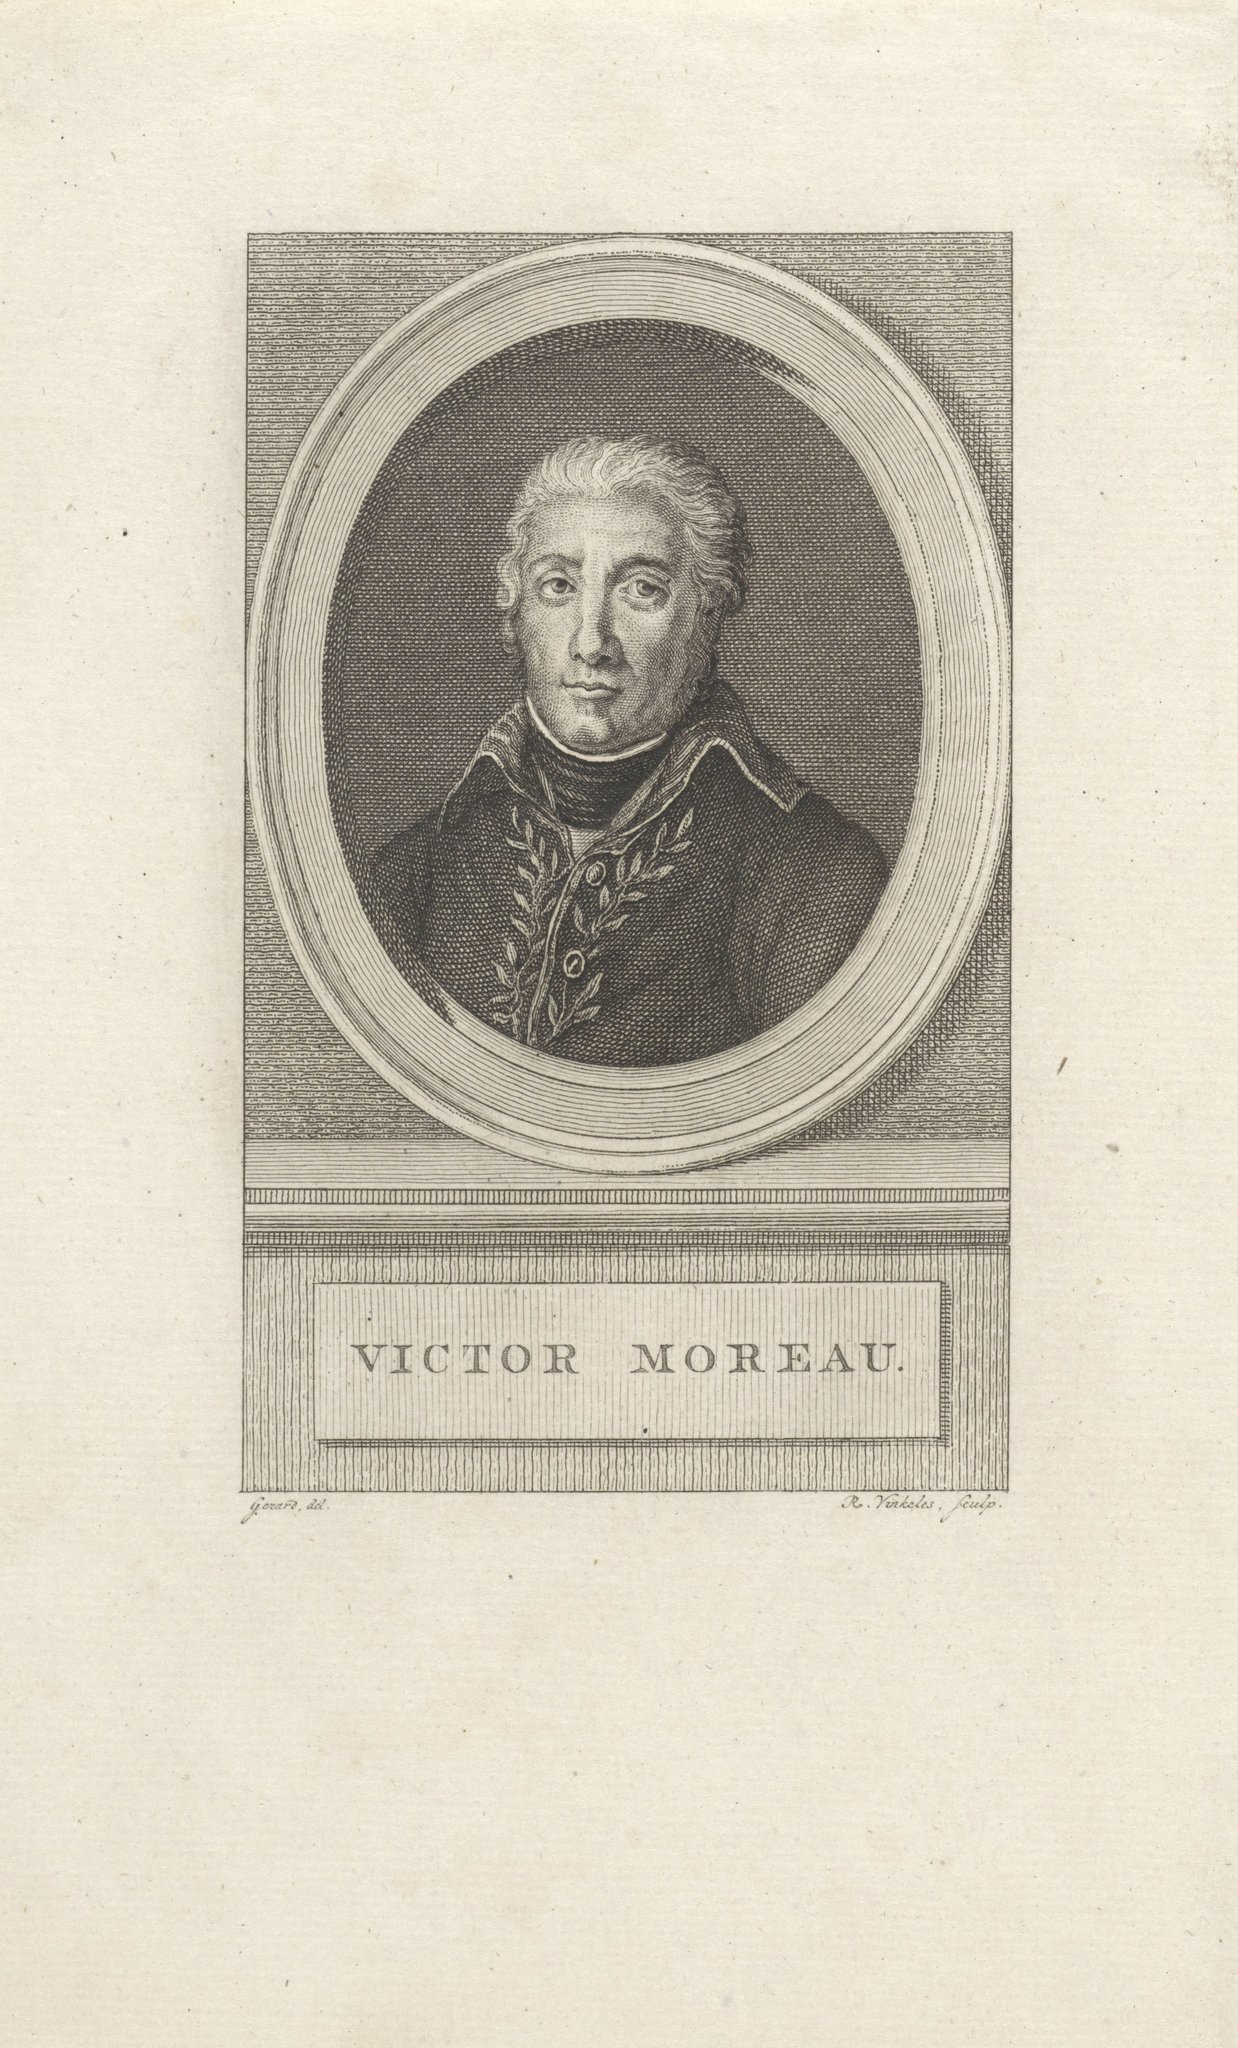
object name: print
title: Portret van Jean Victor Marie Moreau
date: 1786-1809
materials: paper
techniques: engraving, etching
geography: amsterdam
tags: morlaix, louny, militair, generaal, jean victor marie moreau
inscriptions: collector's mark: Lugt 2228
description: Prent vermoedelijk gebruikt als boekillustratie in: Wagenaar, Jan. Vaderlandsche historie, (...) ten vervolge van Wagenaars Vaderlandsche historie. Dl. 1-43. Amsterdam: Johannes Allart, 1786-1809.